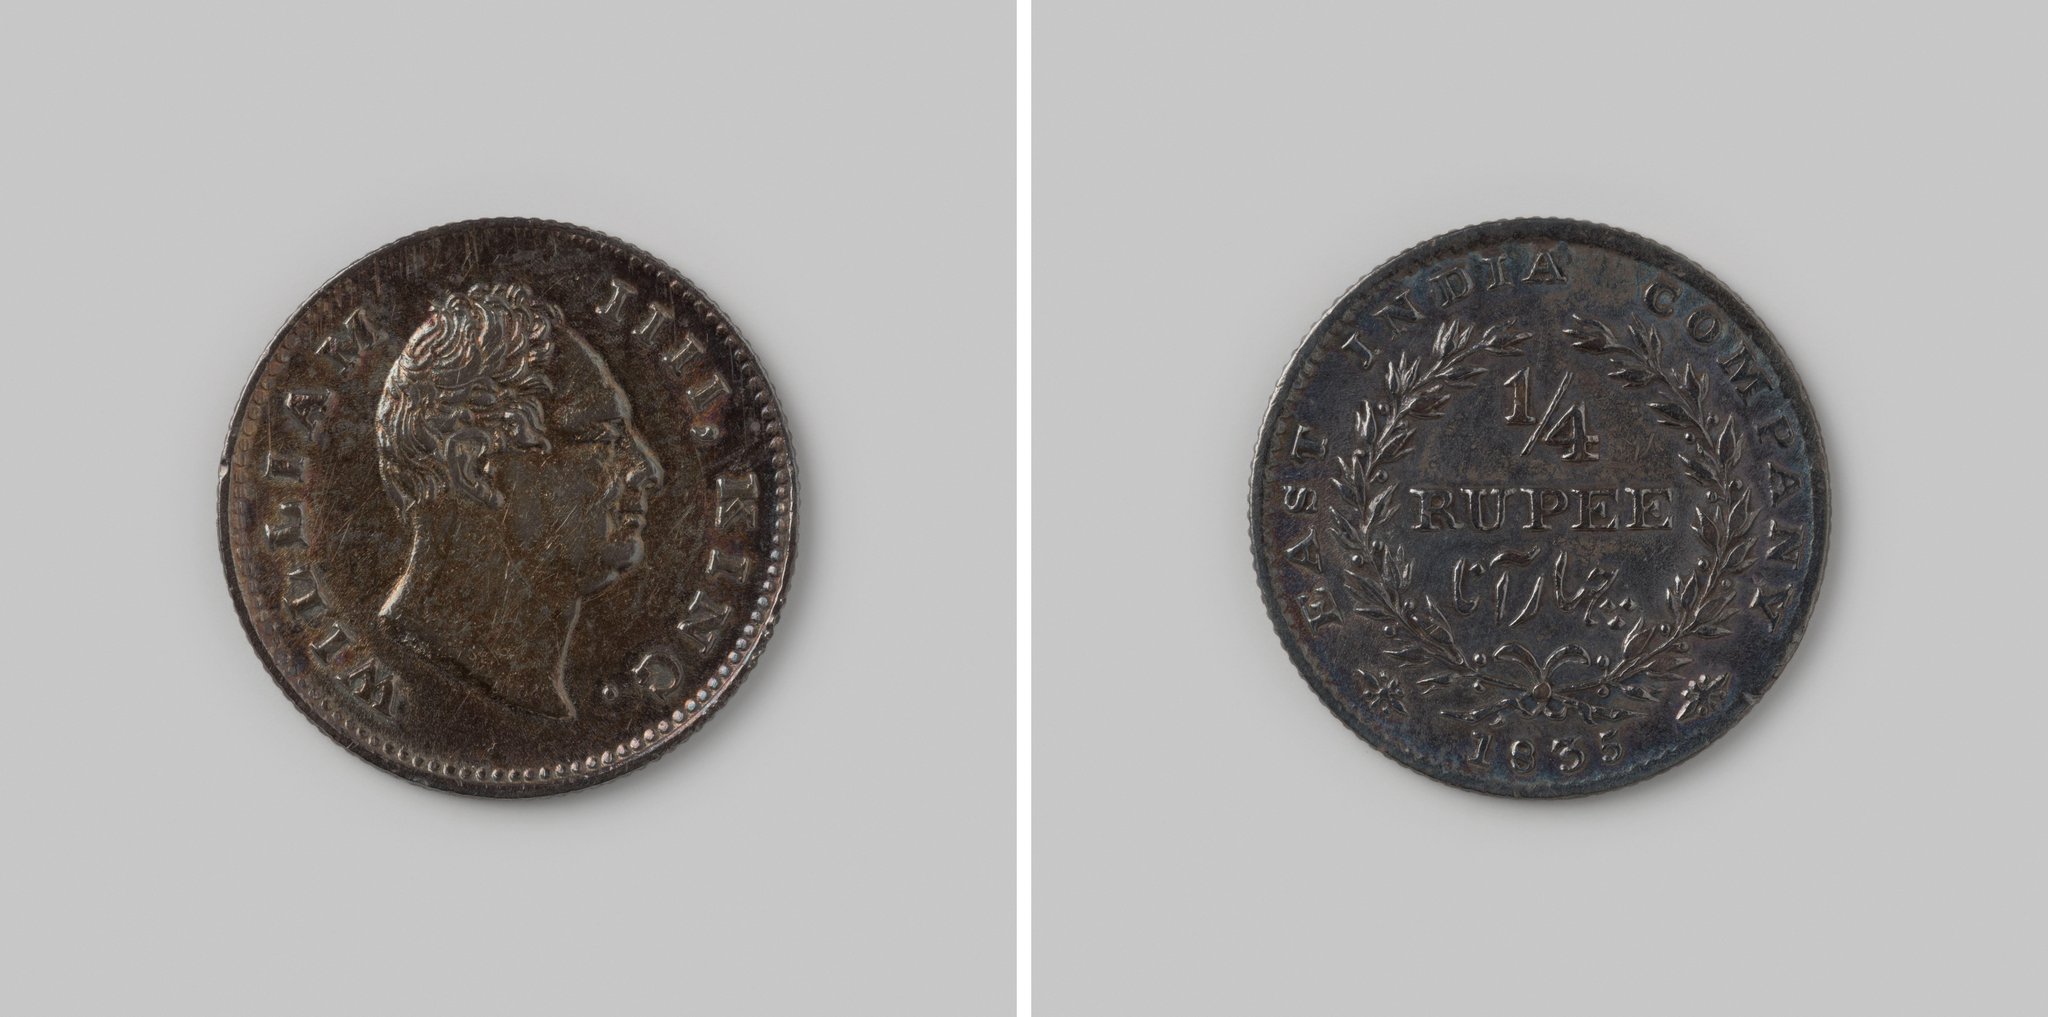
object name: coin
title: India, Engelse Oostindische Compagnie (EIC), op naam van koning William IV, 1/4 roepie, 1835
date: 1835-1840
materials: silver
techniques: striking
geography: kolkata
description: Zilveren munt. Voorzijde: hoofd van koning William IV naar rechts. Op halsafsnede inwendige letters RS [= Calcutta]. Keerzijde: tussen twee samengebonden takken in twee regels waarde-aanduiding: 1/4 rupee, waaronder in Arabische lettertekens in een regel waarde-aanduiding. Onderaan jaartal. Kartelrand.